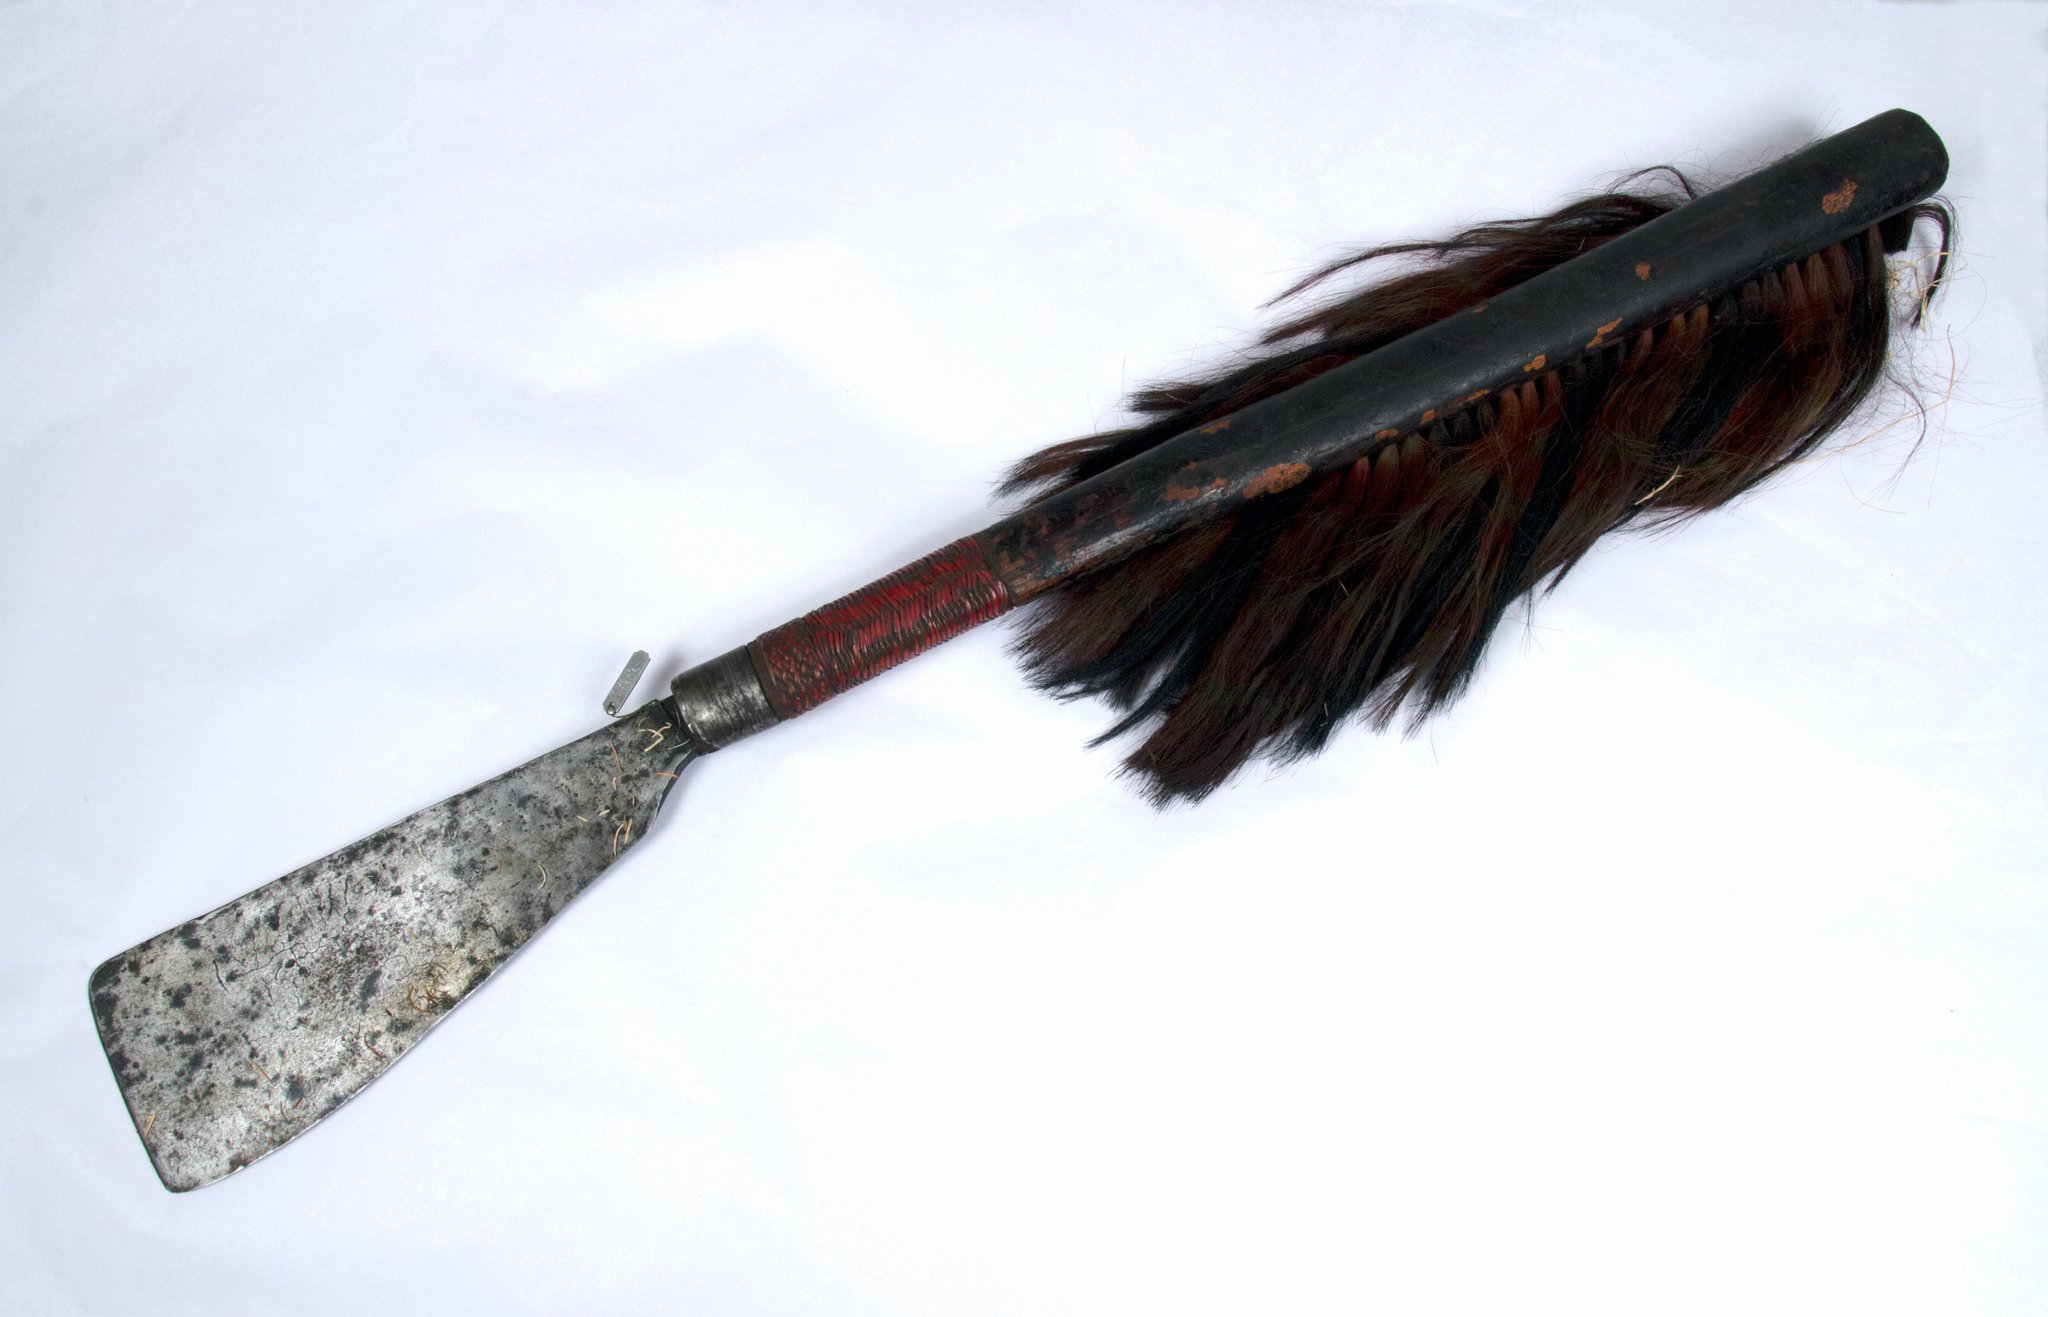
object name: axe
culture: indian, assam, naga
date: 1801-1900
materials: hair, steel, wood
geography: india